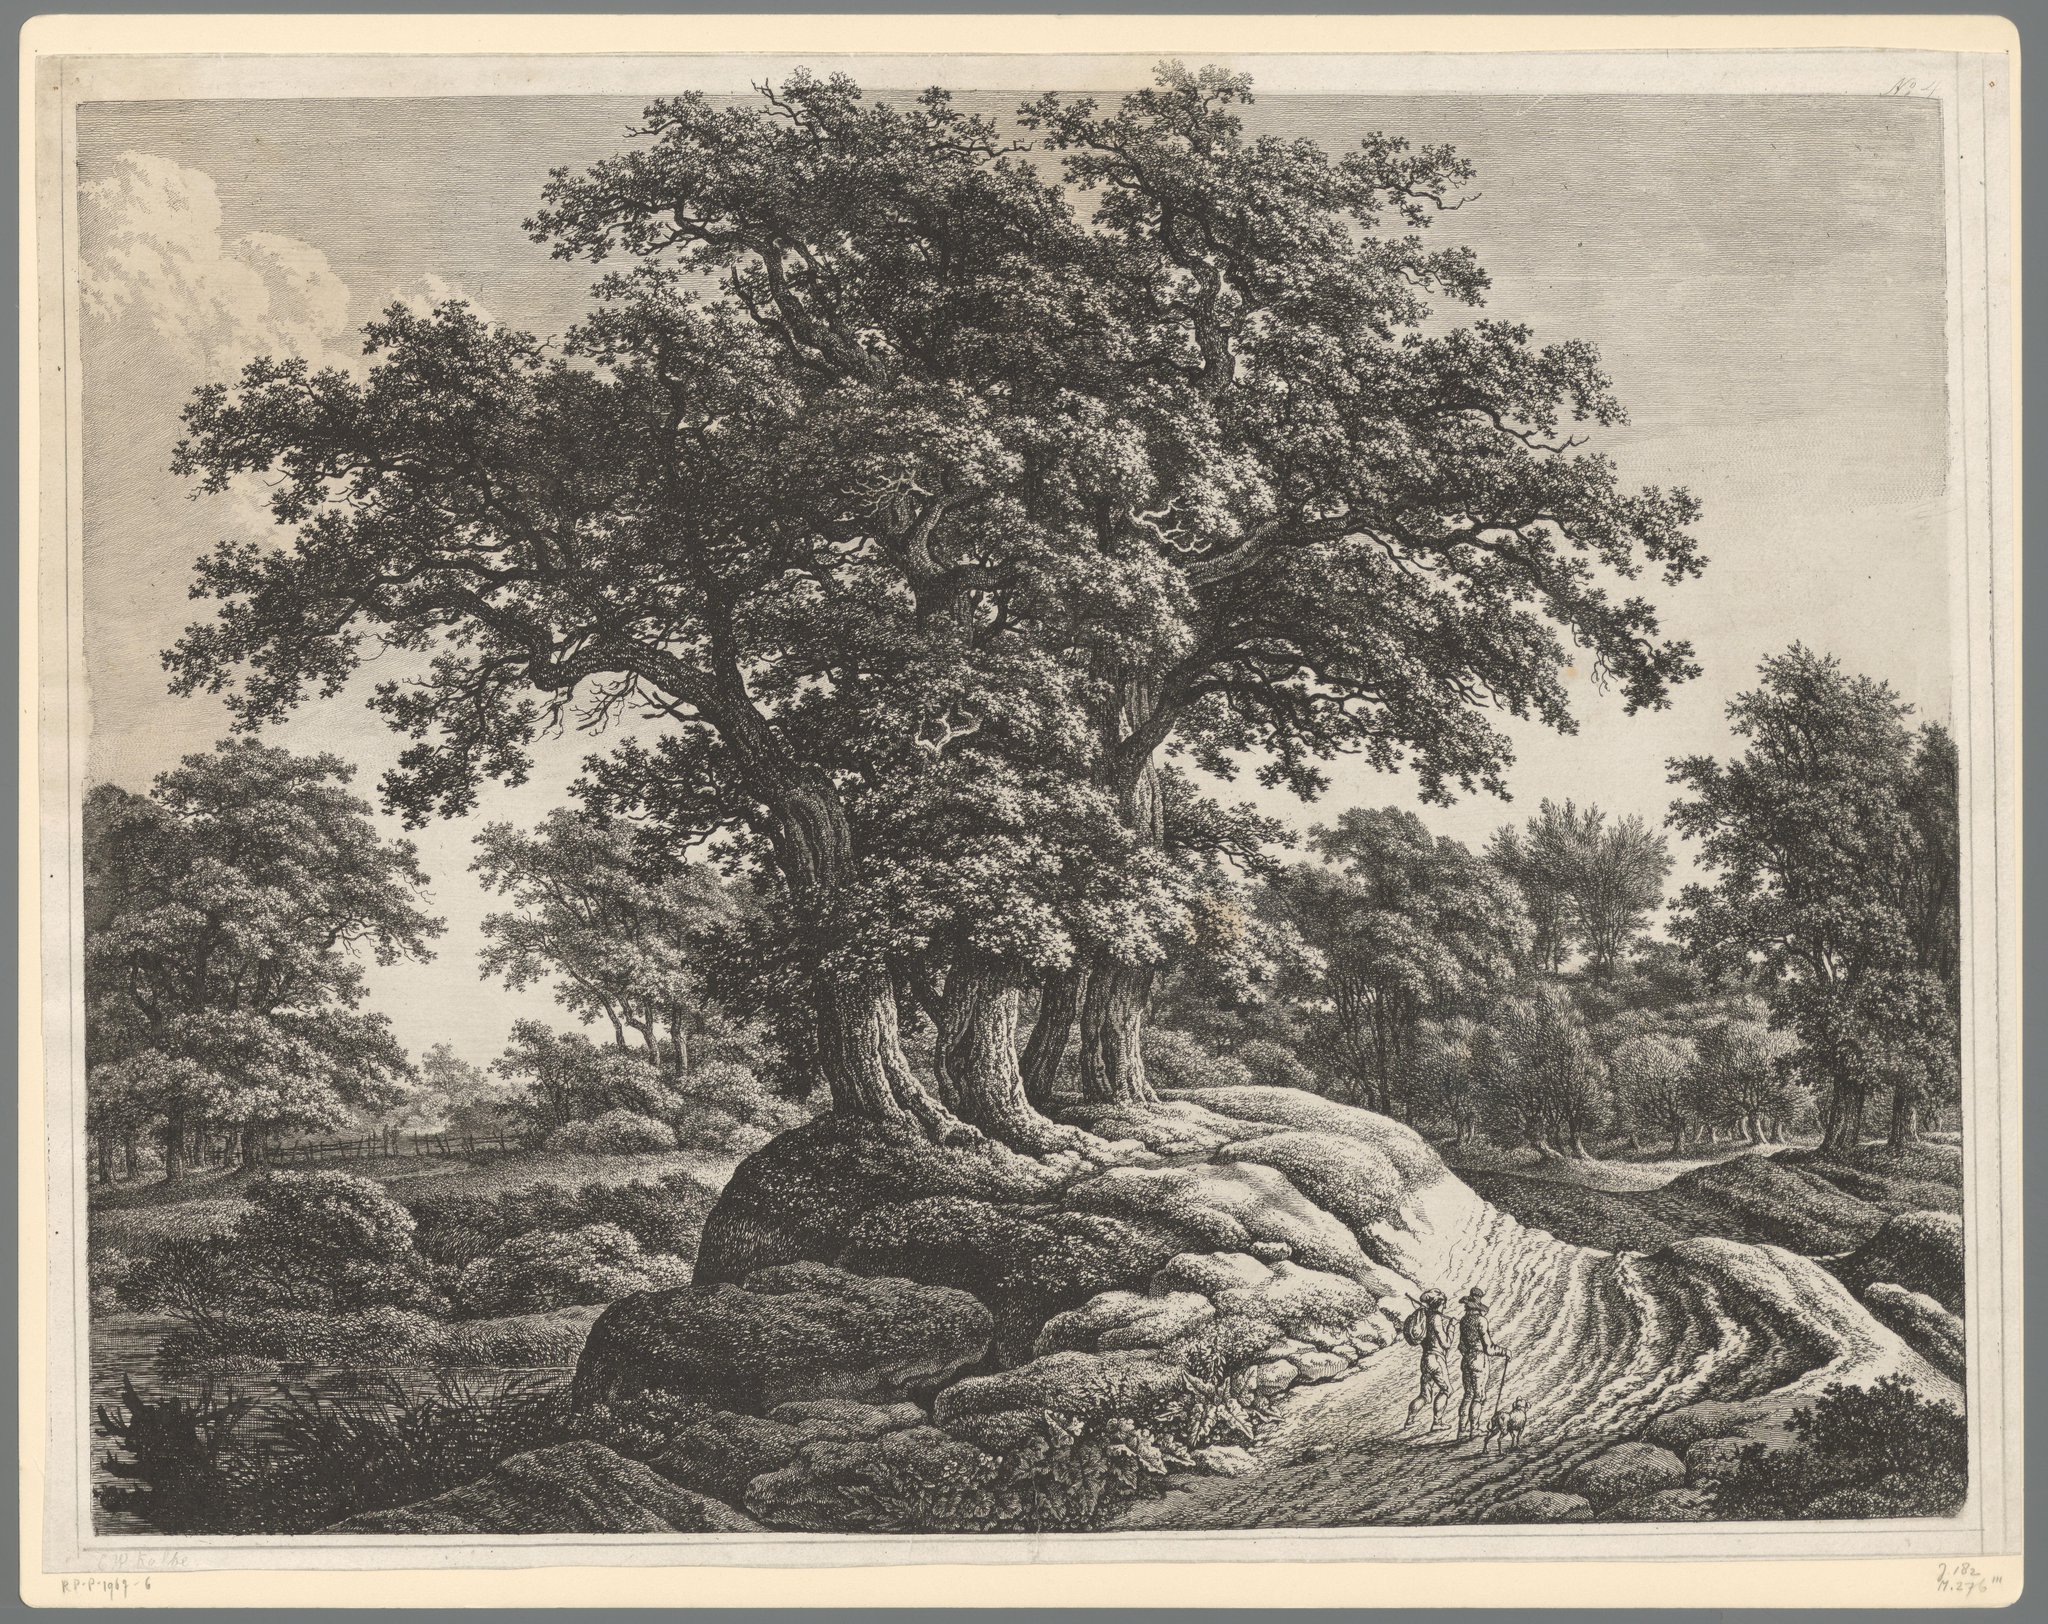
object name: print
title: Bosrijk landschap met twee wandelaars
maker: carl wilhelm kolbe (i)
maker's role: print maker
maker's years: 1757-1835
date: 1767-1835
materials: paper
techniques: etching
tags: groups of trees, forest path or lane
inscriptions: collector's mark: Lugt 2760, collector's mark: Lugt 2228, number: ‘4’